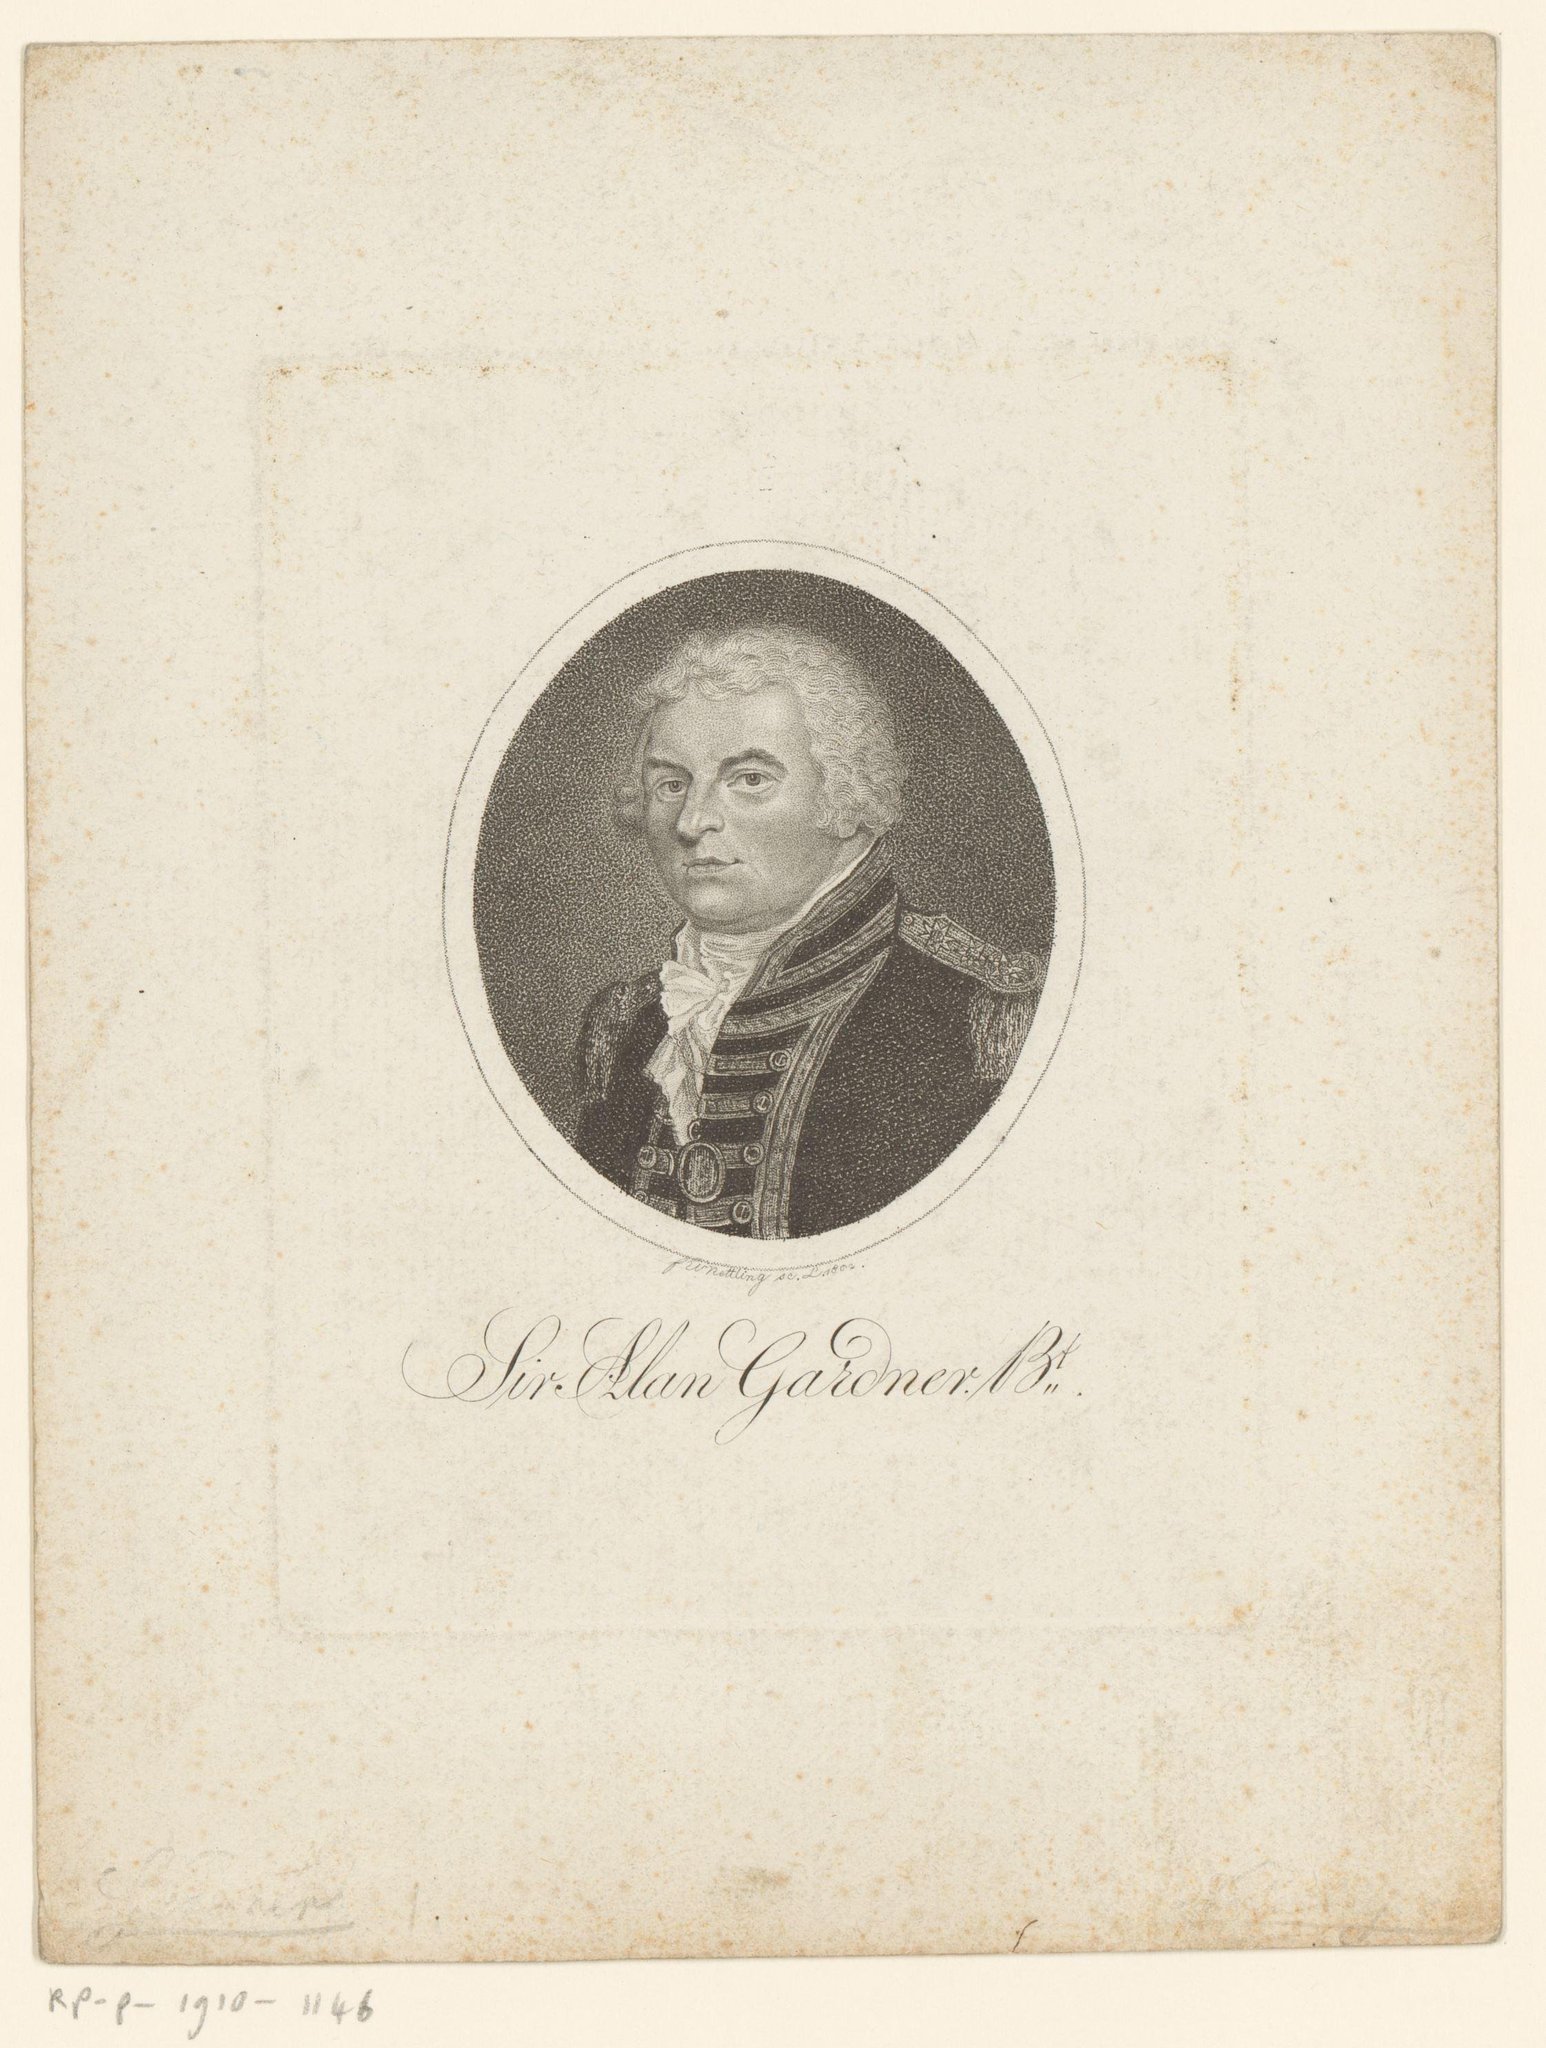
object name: print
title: Portret van Alan Gardner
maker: friedrich wilhelm nettling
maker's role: print maker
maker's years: 1793-1824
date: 1793-1824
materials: paper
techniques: engraving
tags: historical persons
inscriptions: collector's mark: Lugt 2228